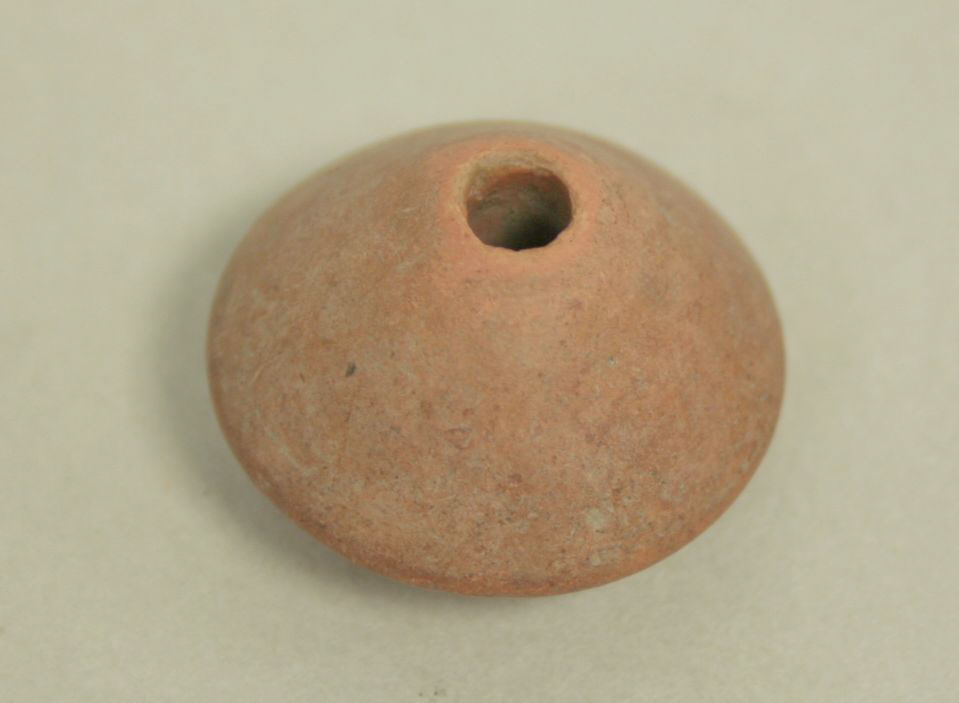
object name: spindle whorl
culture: peruvian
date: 1-500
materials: ceramic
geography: peru